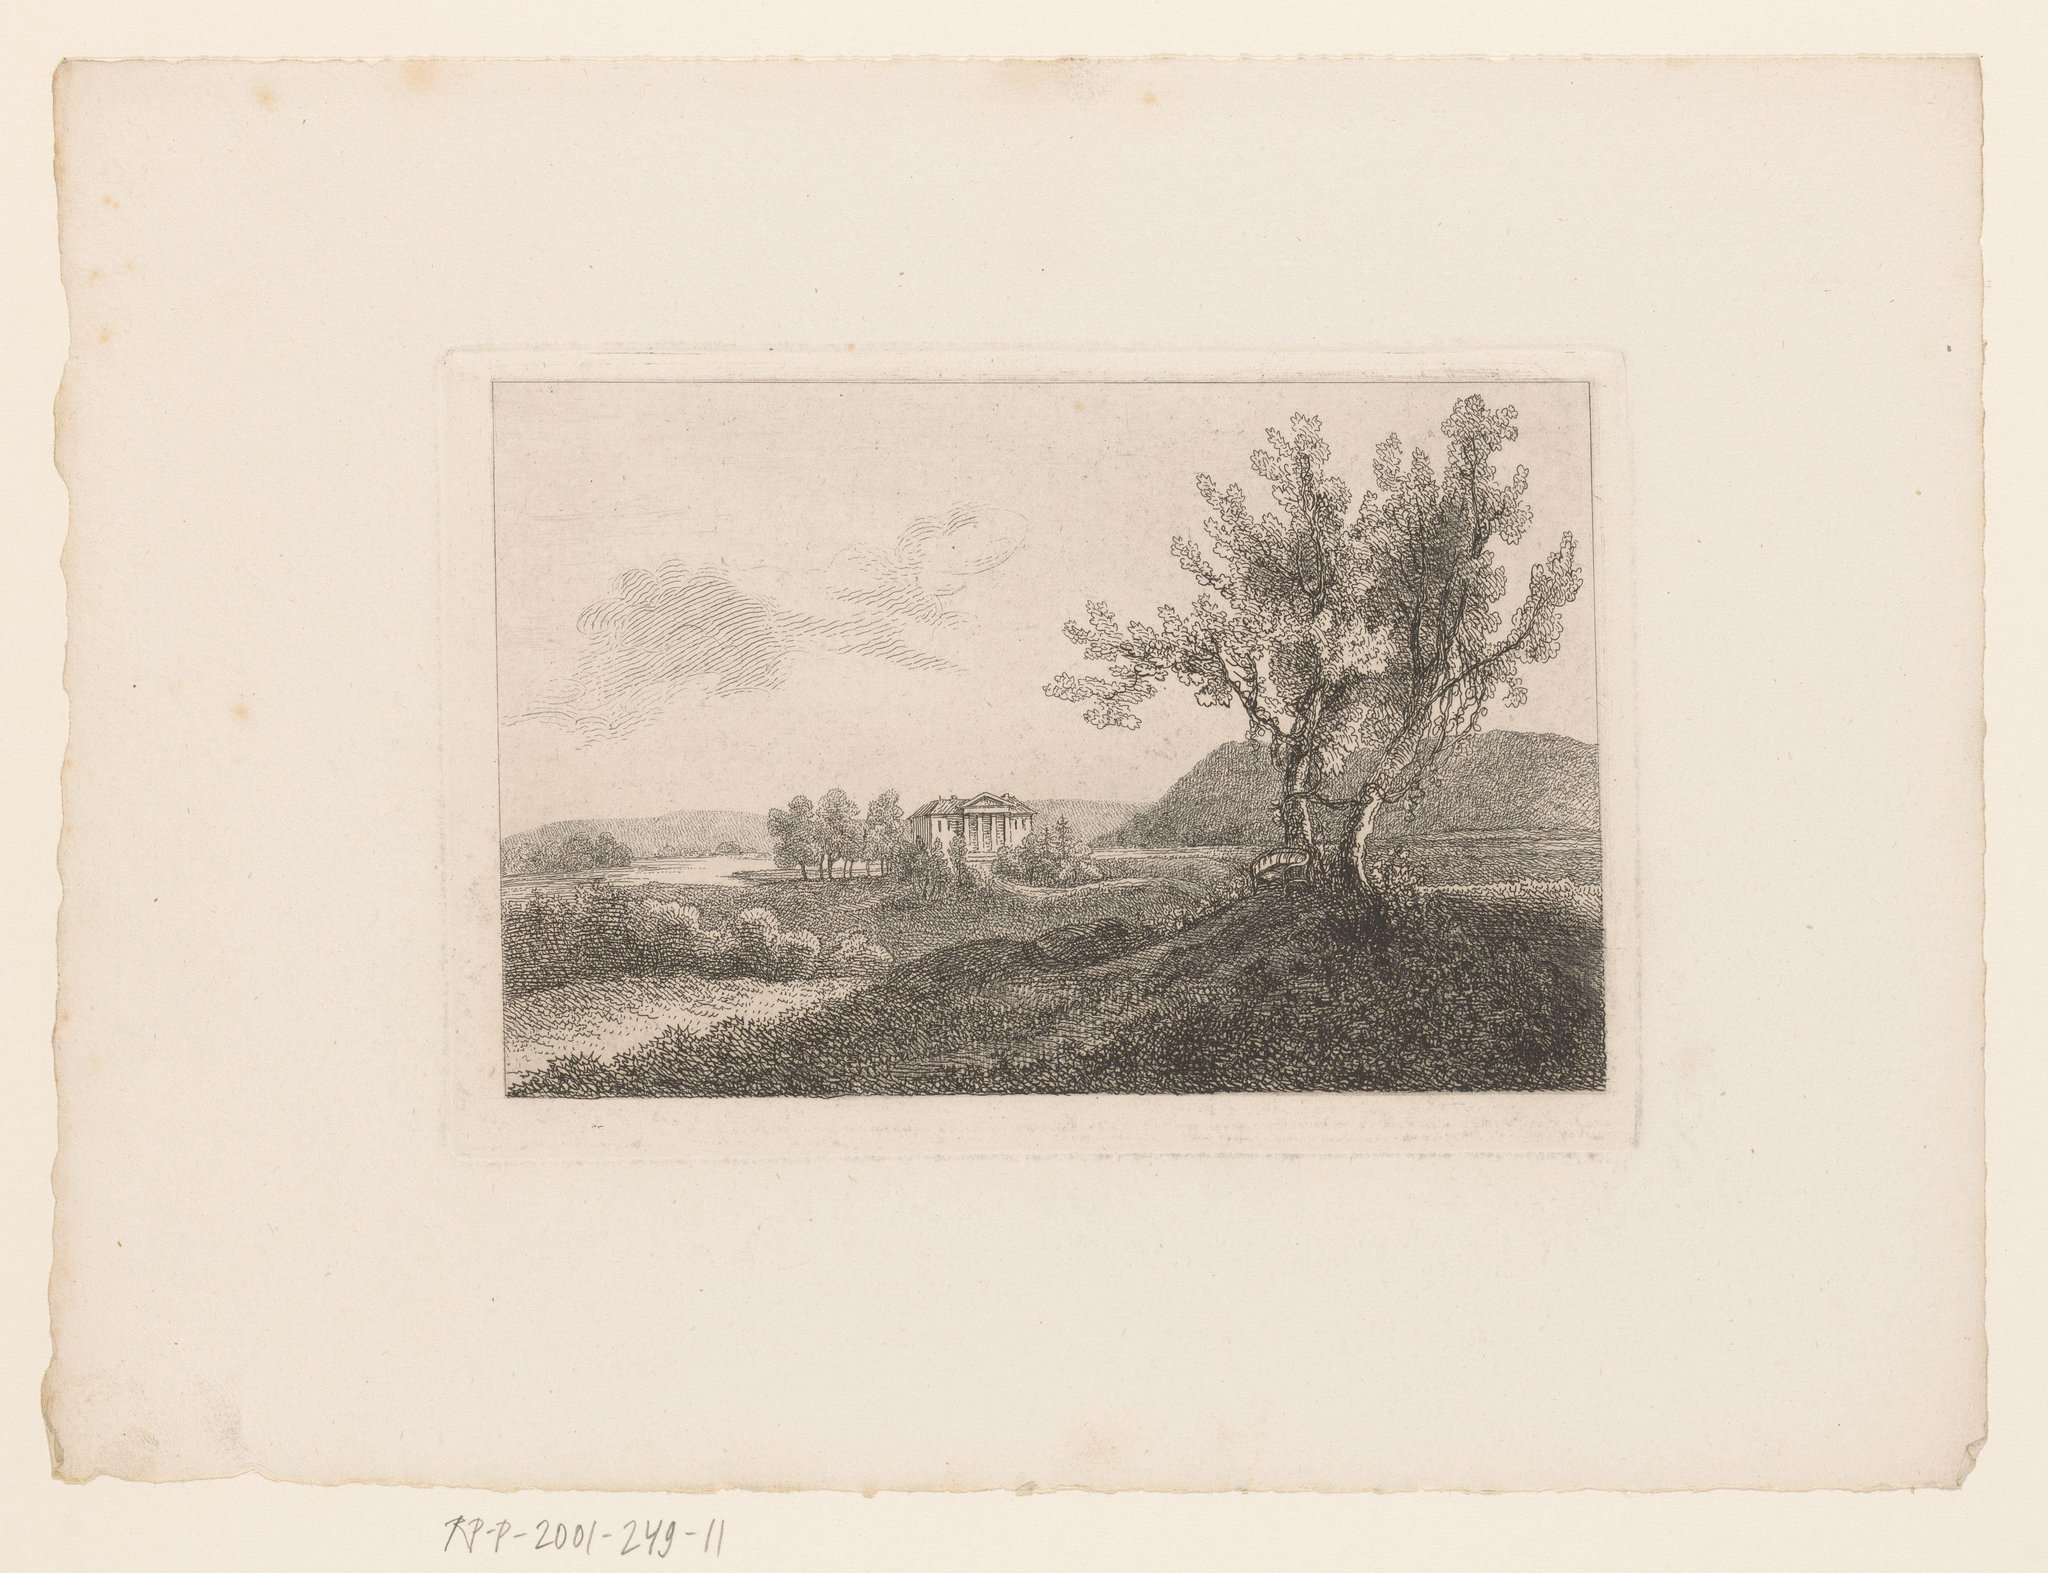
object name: print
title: Mijn eerste etsproeven in een reeks van 28 bladen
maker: marie anna fischer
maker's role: print maker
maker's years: 1782-1844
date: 1804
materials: paper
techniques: etching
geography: vienna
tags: bench, landscapes, villa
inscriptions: collector's mark: Lugt 2228, collector's mark: Lugt 2760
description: De originele prentserie bevat 40 prenten op 28 bladen. Het RMA heeft 33 prenten op 22 bladen in de collectie.